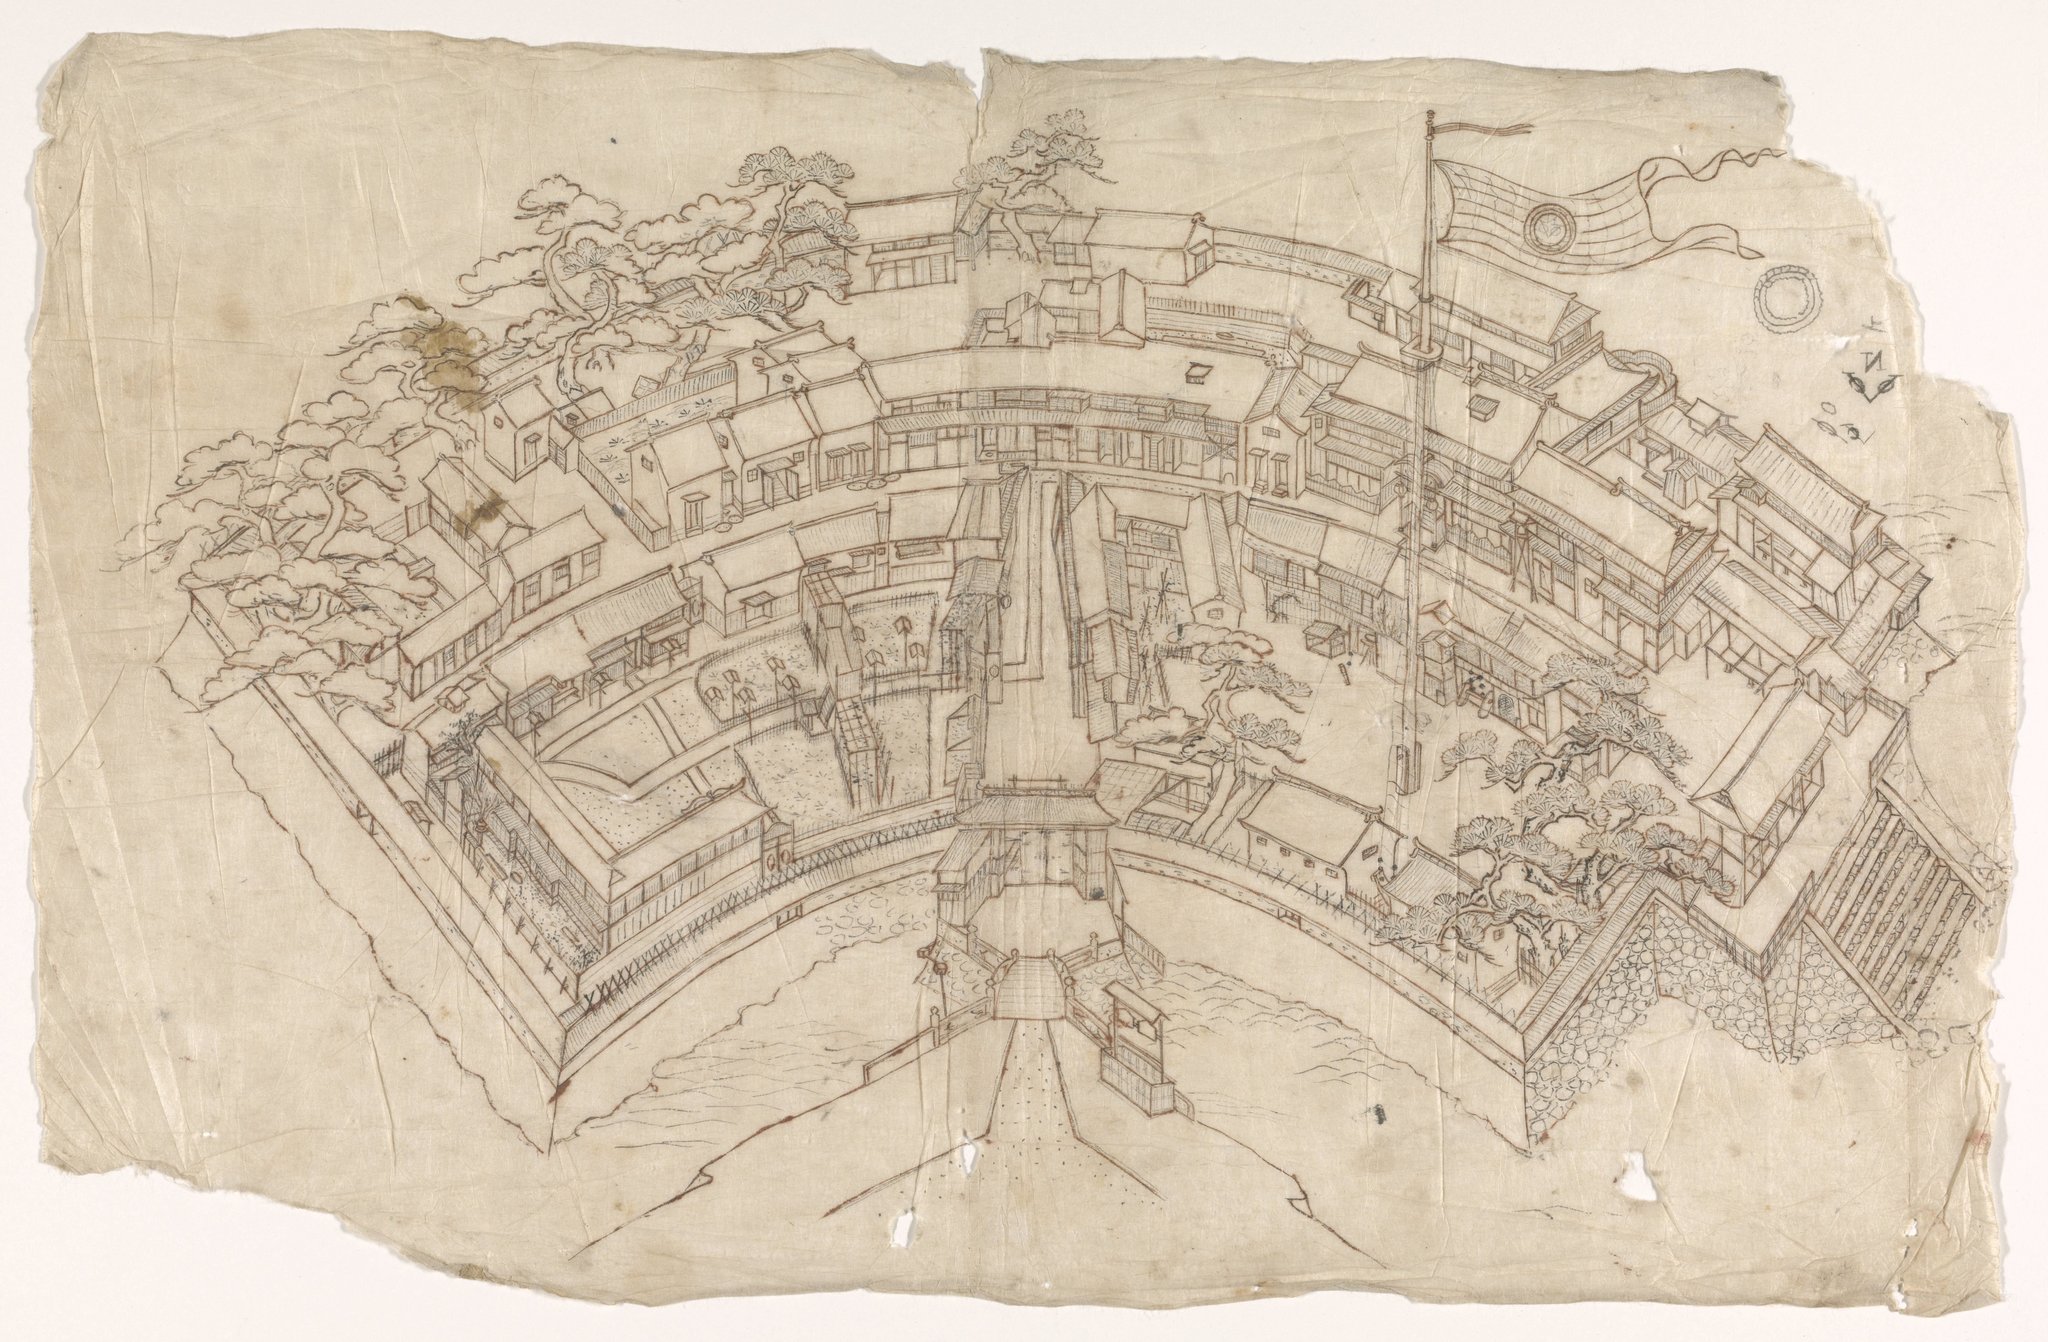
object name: design drawing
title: Deshima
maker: sasaya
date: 1800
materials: ink, lacquer, paint, paper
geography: kyoto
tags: deshima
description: Ontwerptekening voor een paneel van lakwerk met voorstelling van het eiland Deshima (NG-NM-9346).